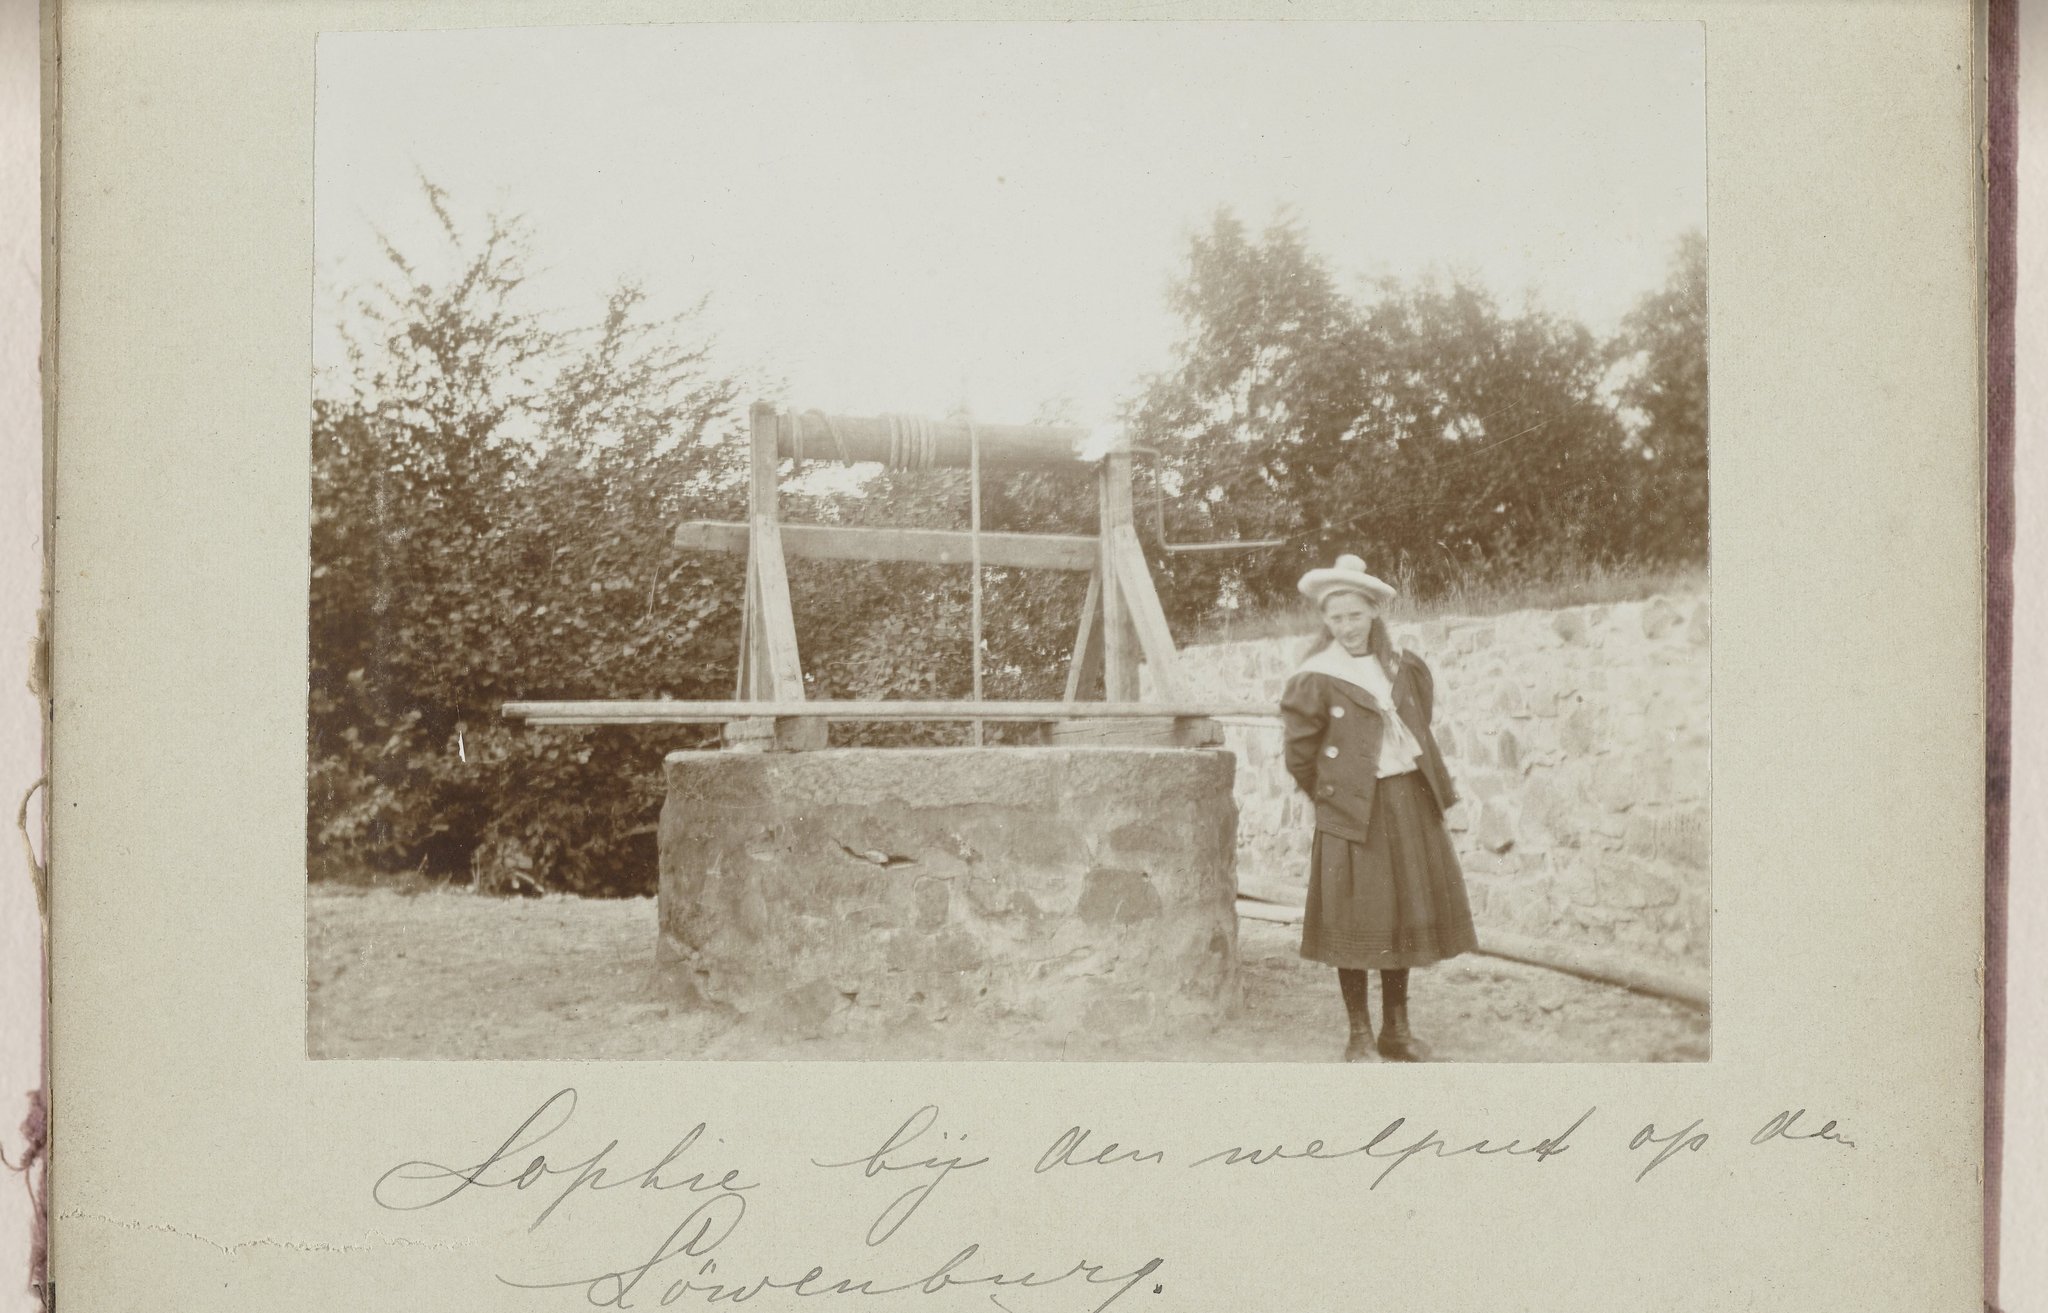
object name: album leaf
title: Sophie Vermeulen bij een put op de Löwenburg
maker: david vermeulen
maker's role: fotograaf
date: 1895-1905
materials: paper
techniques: collodion silver print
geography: löwenburg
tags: well, girl (child between toddler and youth)